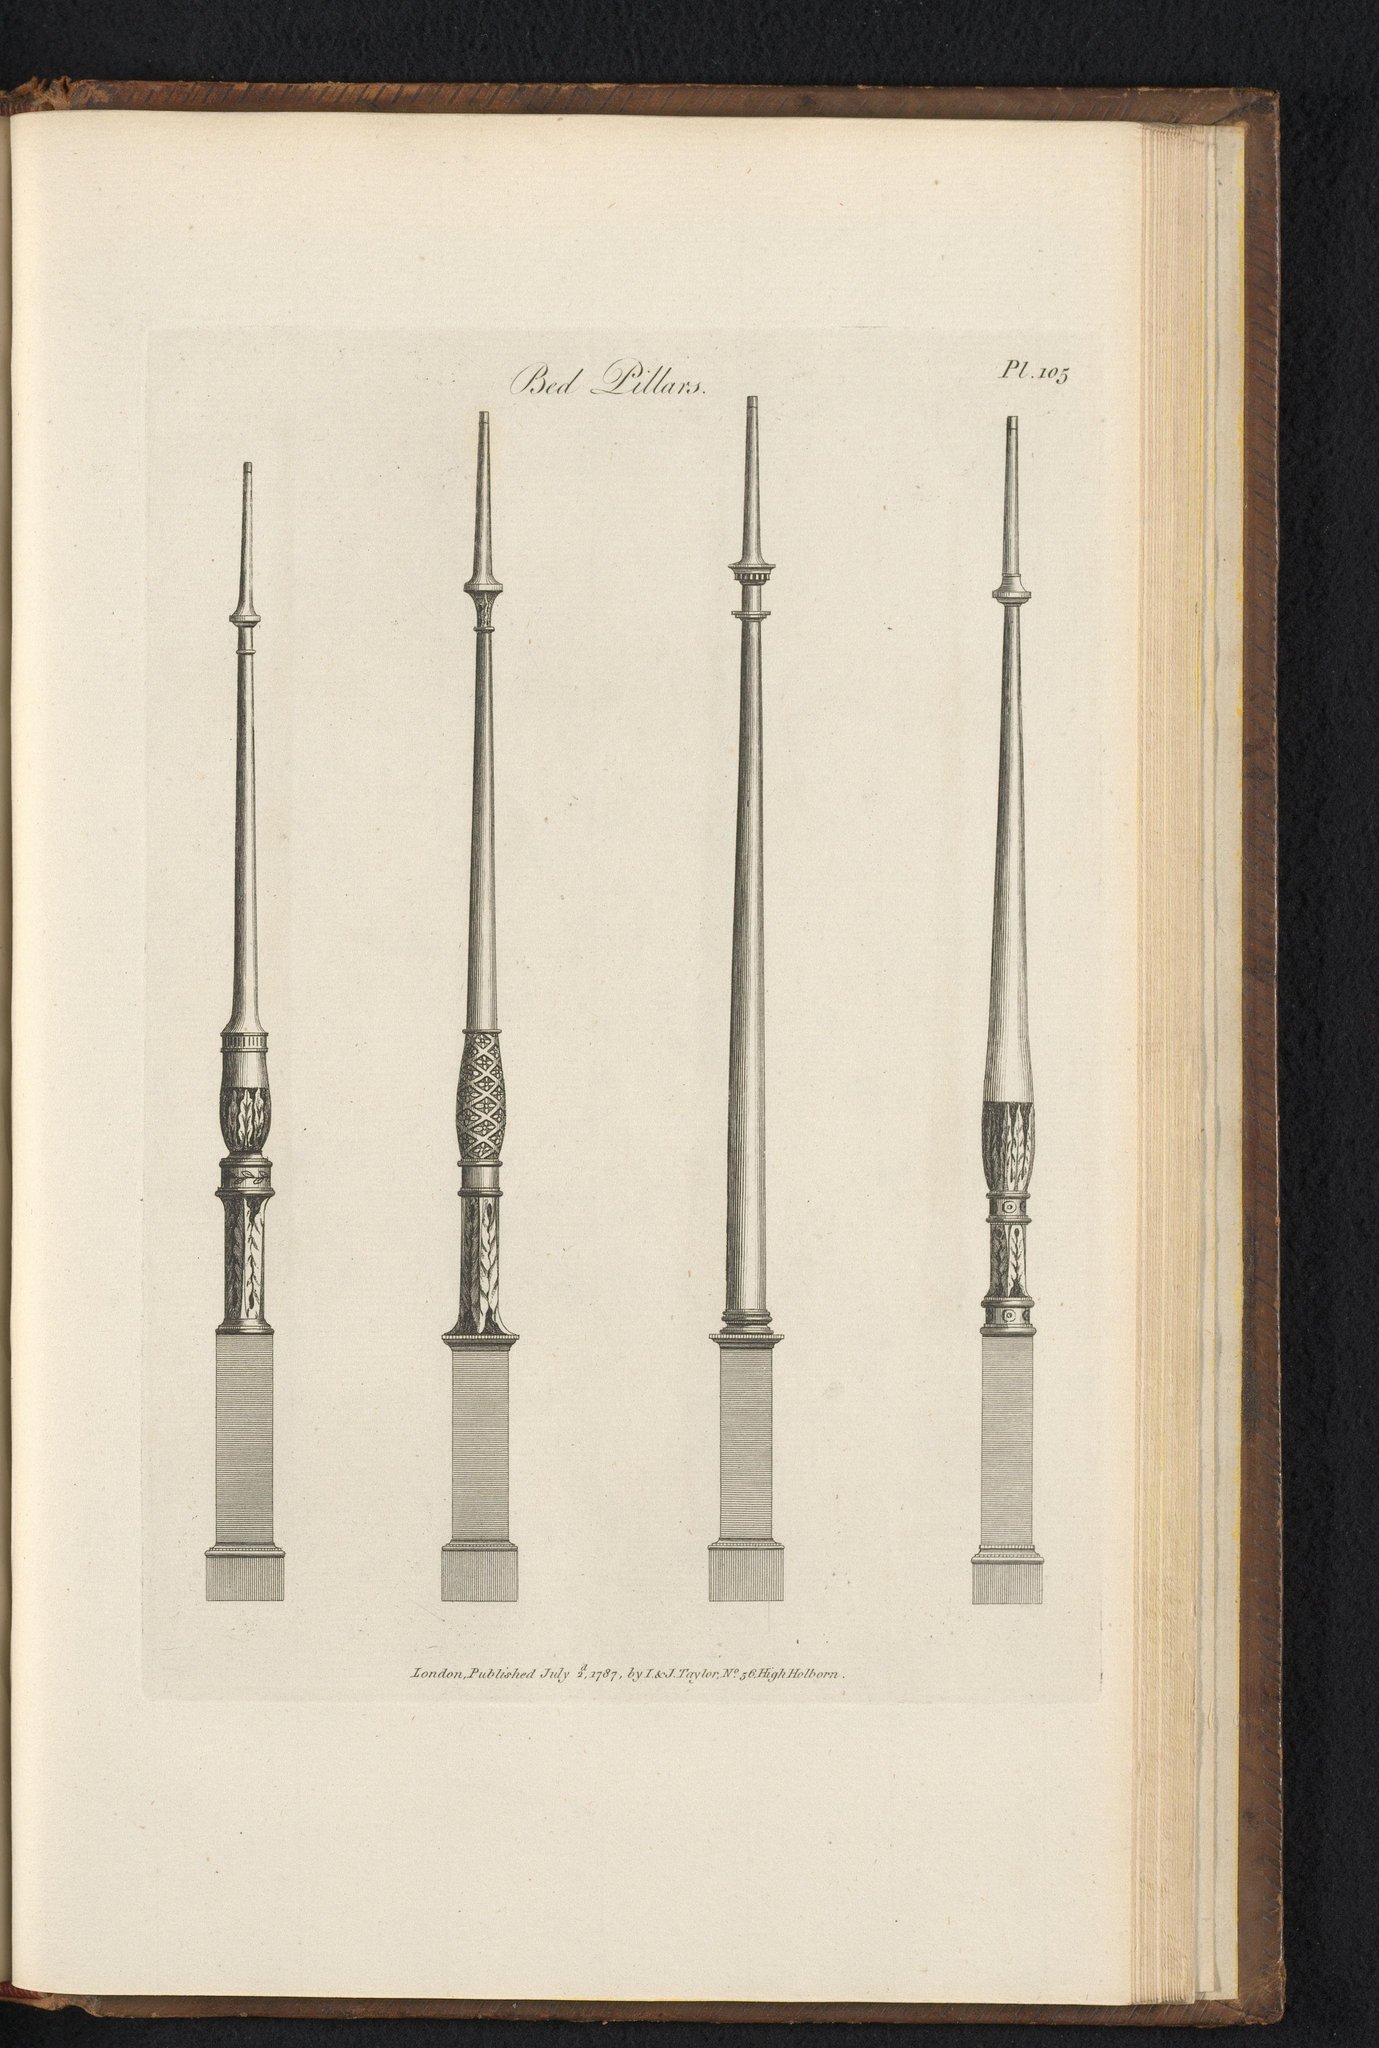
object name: print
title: Meubels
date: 1787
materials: paper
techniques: engraving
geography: holborn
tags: tent-camp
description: Genummerd: Pl. 105. Prent maakt deel uit van een boek.